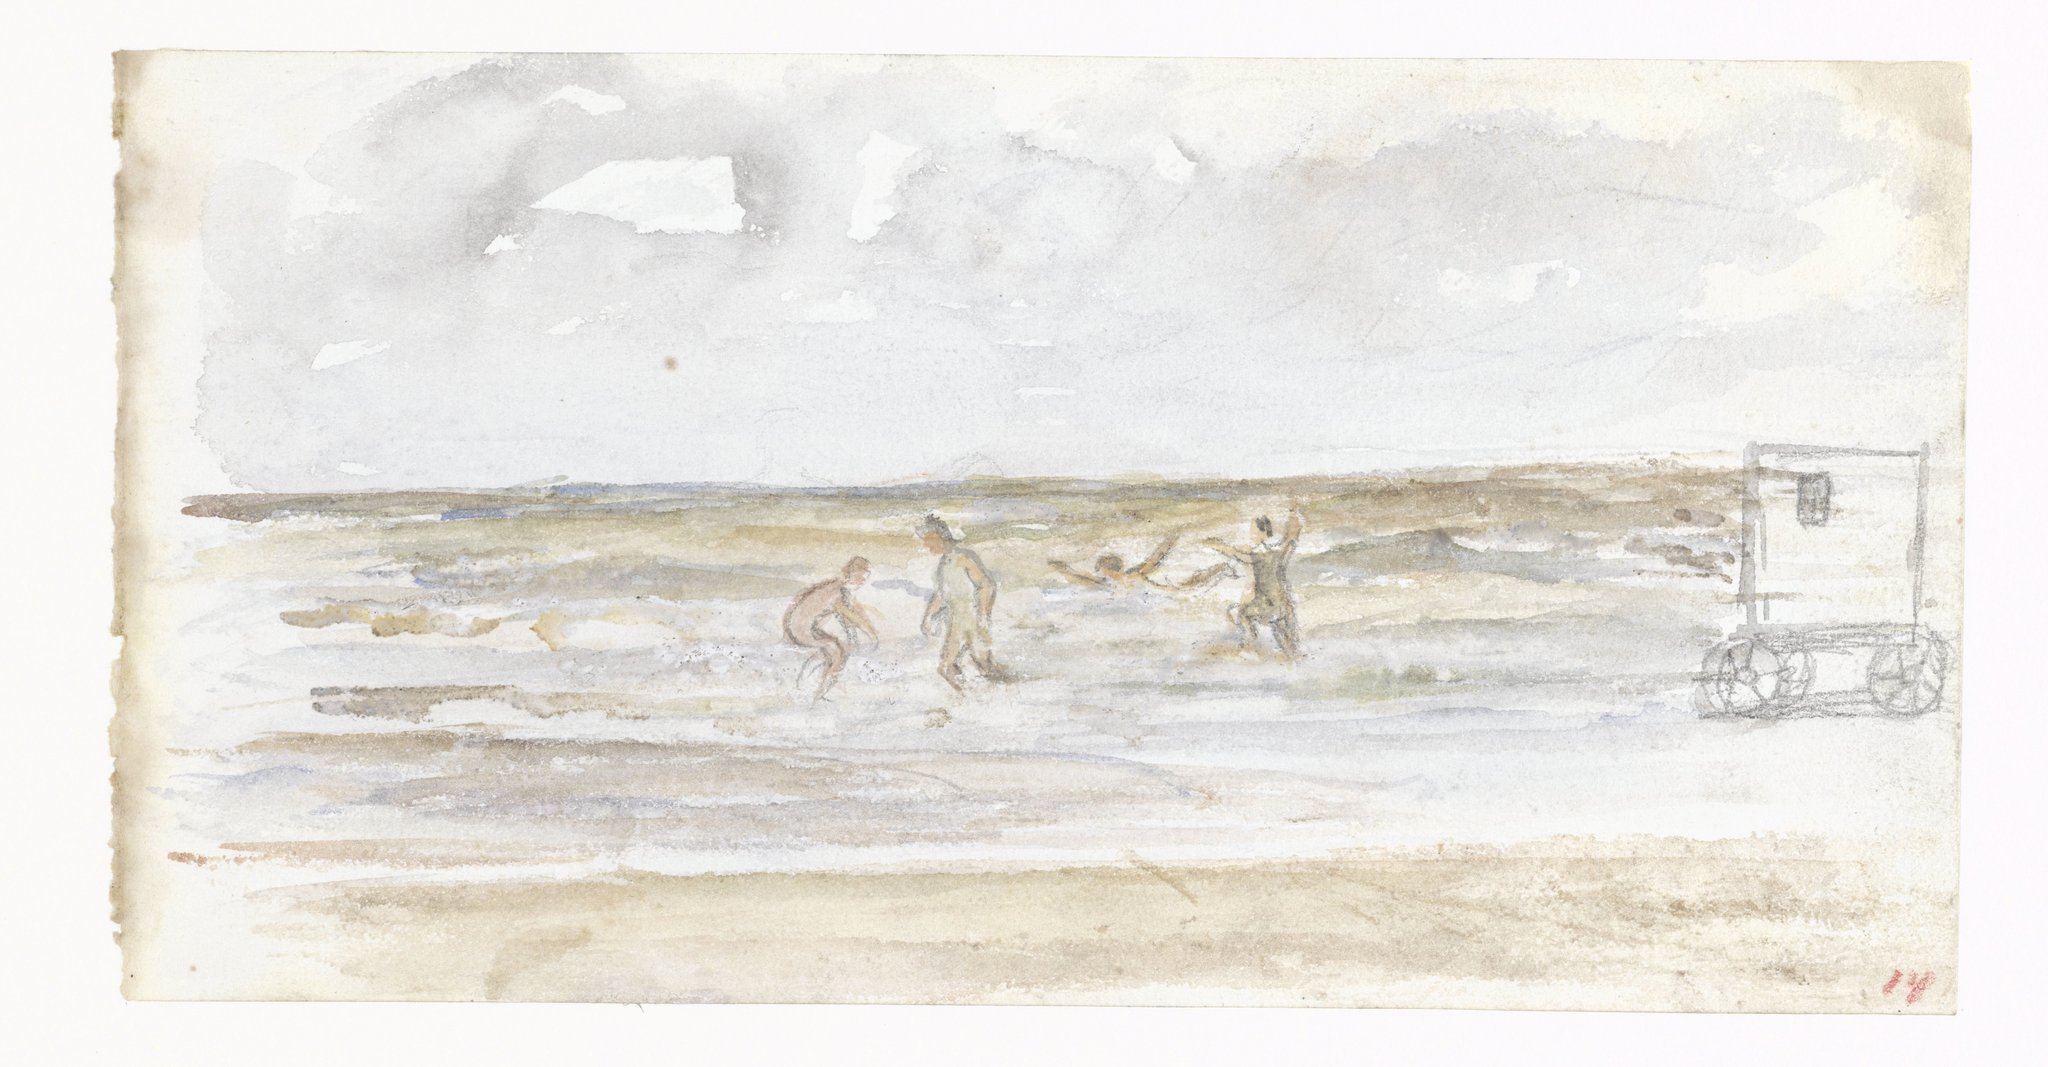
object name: watercolor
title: Baders in zee en een strandkoets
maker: jozef israëls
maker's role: draughtsman, painter, print maker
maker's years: 1824-1911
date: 1834-1911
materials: paper, pencil, watercolor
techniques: brush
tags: in or beside the water (on the beach)